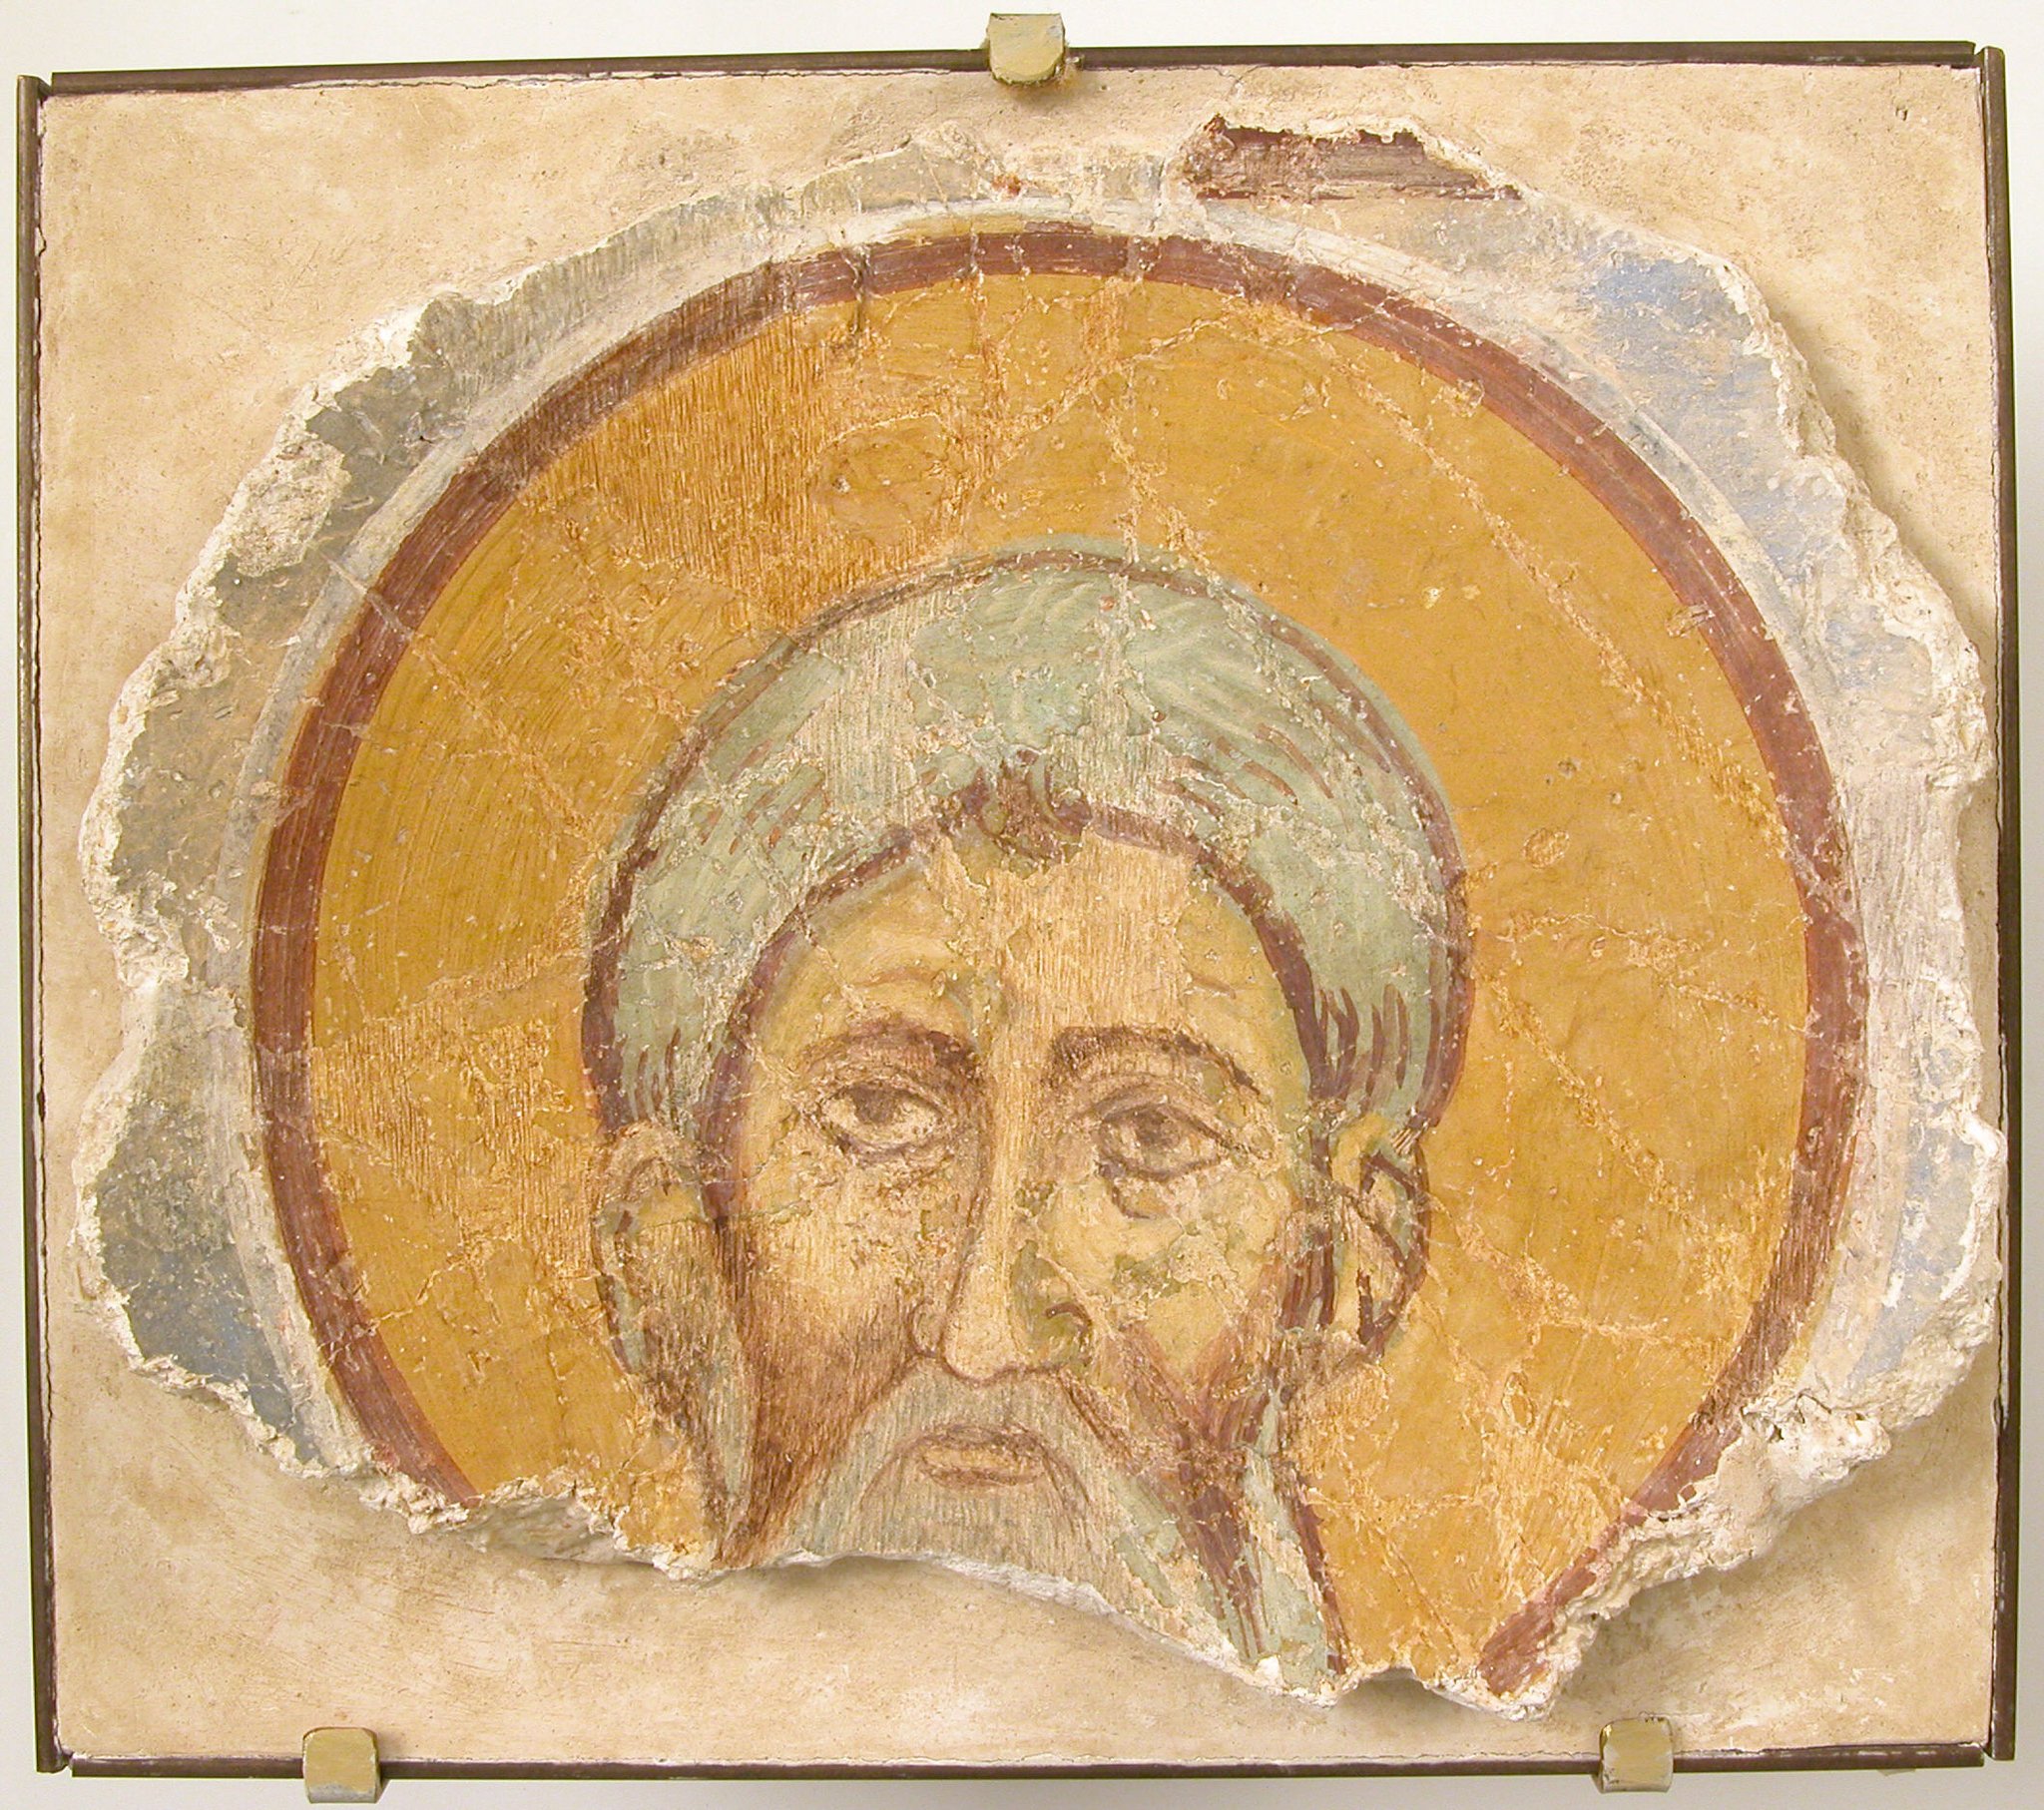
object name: painting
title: Wall Painting of a Male Saint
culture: byzantine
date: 1101-1200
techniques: fresco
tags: men,saints